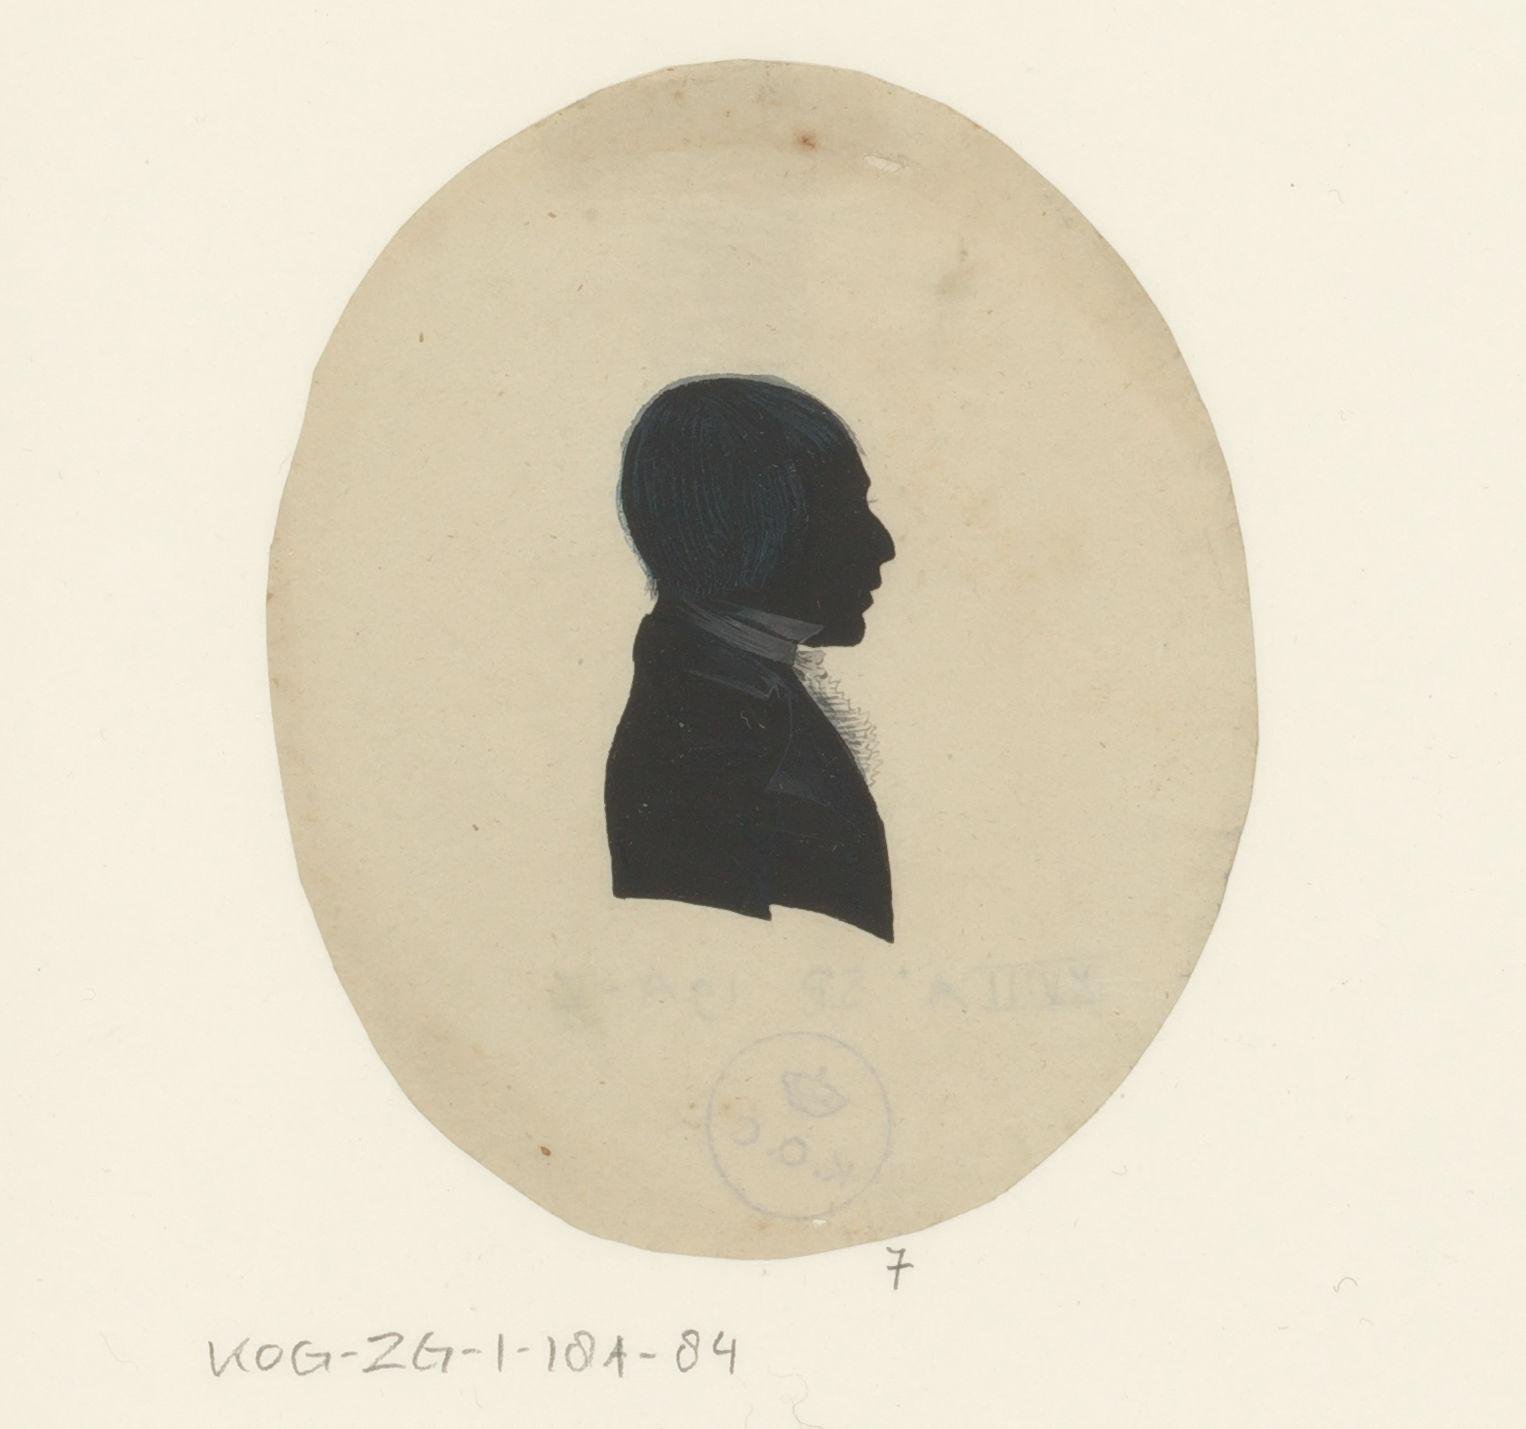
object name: silhouette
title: Silhouetportret van een onbekende man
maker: Anonymous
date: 1775-1849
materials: paint, paper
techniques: brush, pen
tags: neck-gear: collar, historical persons not known by name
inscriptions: stamp, collector's mark: Lugt 1641, collector's mark: Lugt 1641a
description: Onderwerpsrubrieken binnen de Atlas Zeden en Gewoonten: Schoone kunsten, Silhouetportretten.